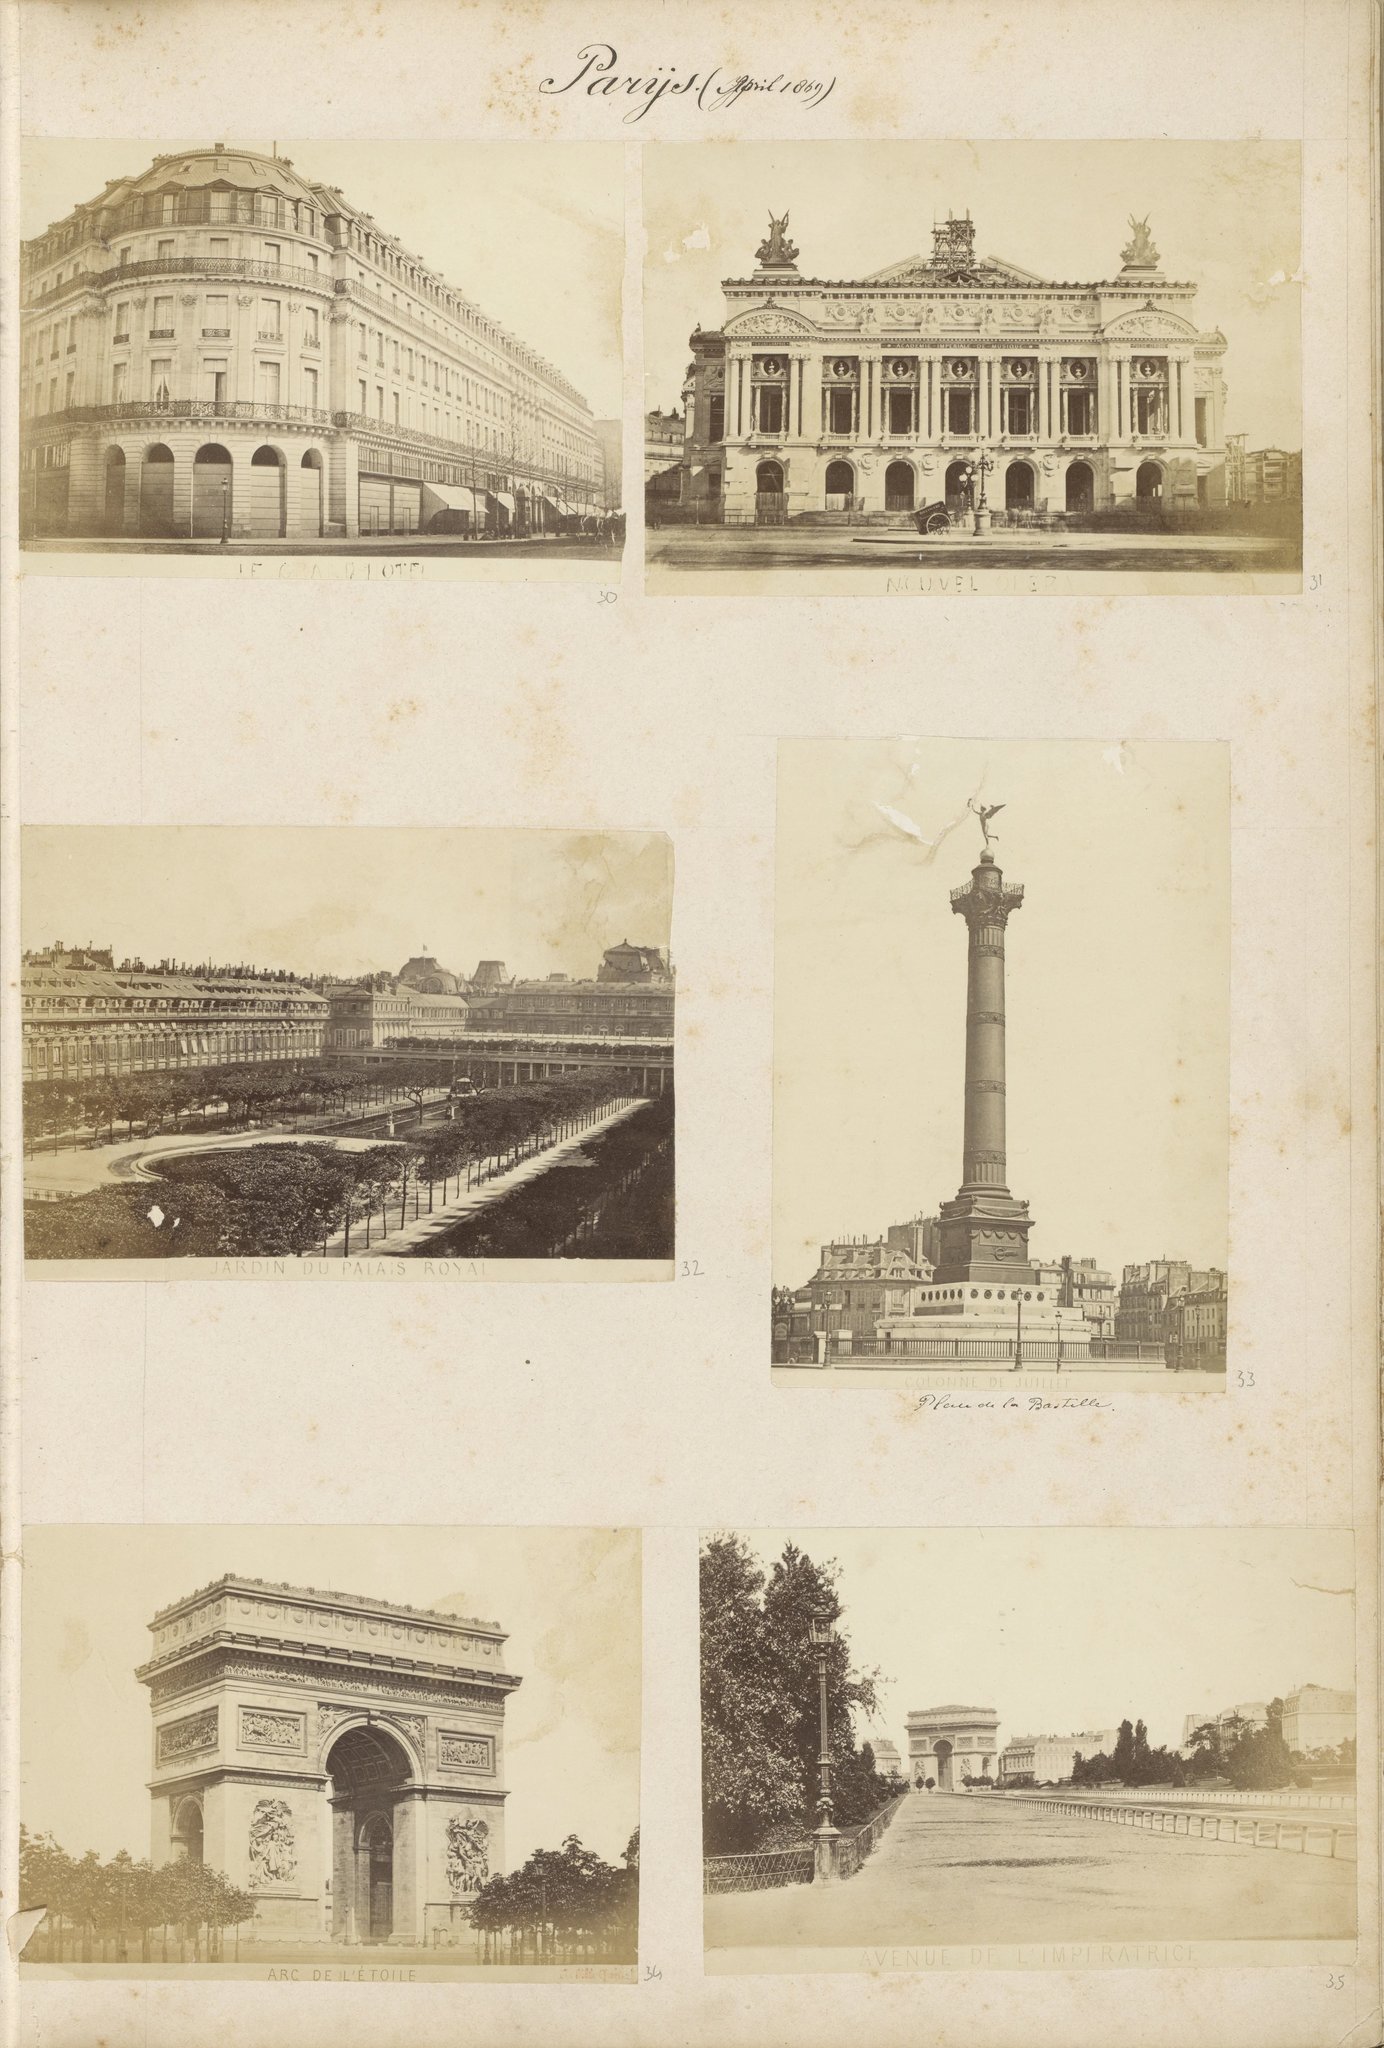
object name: album leaf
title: Colonne de Juillet op de Place de la Bastille in Parijs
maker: Anonymous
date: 1804-1869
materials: paper, photographic support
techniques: albumen print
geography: paris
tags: monument, statue (+ city(-scape) with figures, staffage), square, place, circus, etc. (+ city(-scape) with figures, staffage), paris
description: Onderdeel van Fotoalbum van Robert Daniel Crommelin (1841-1907).